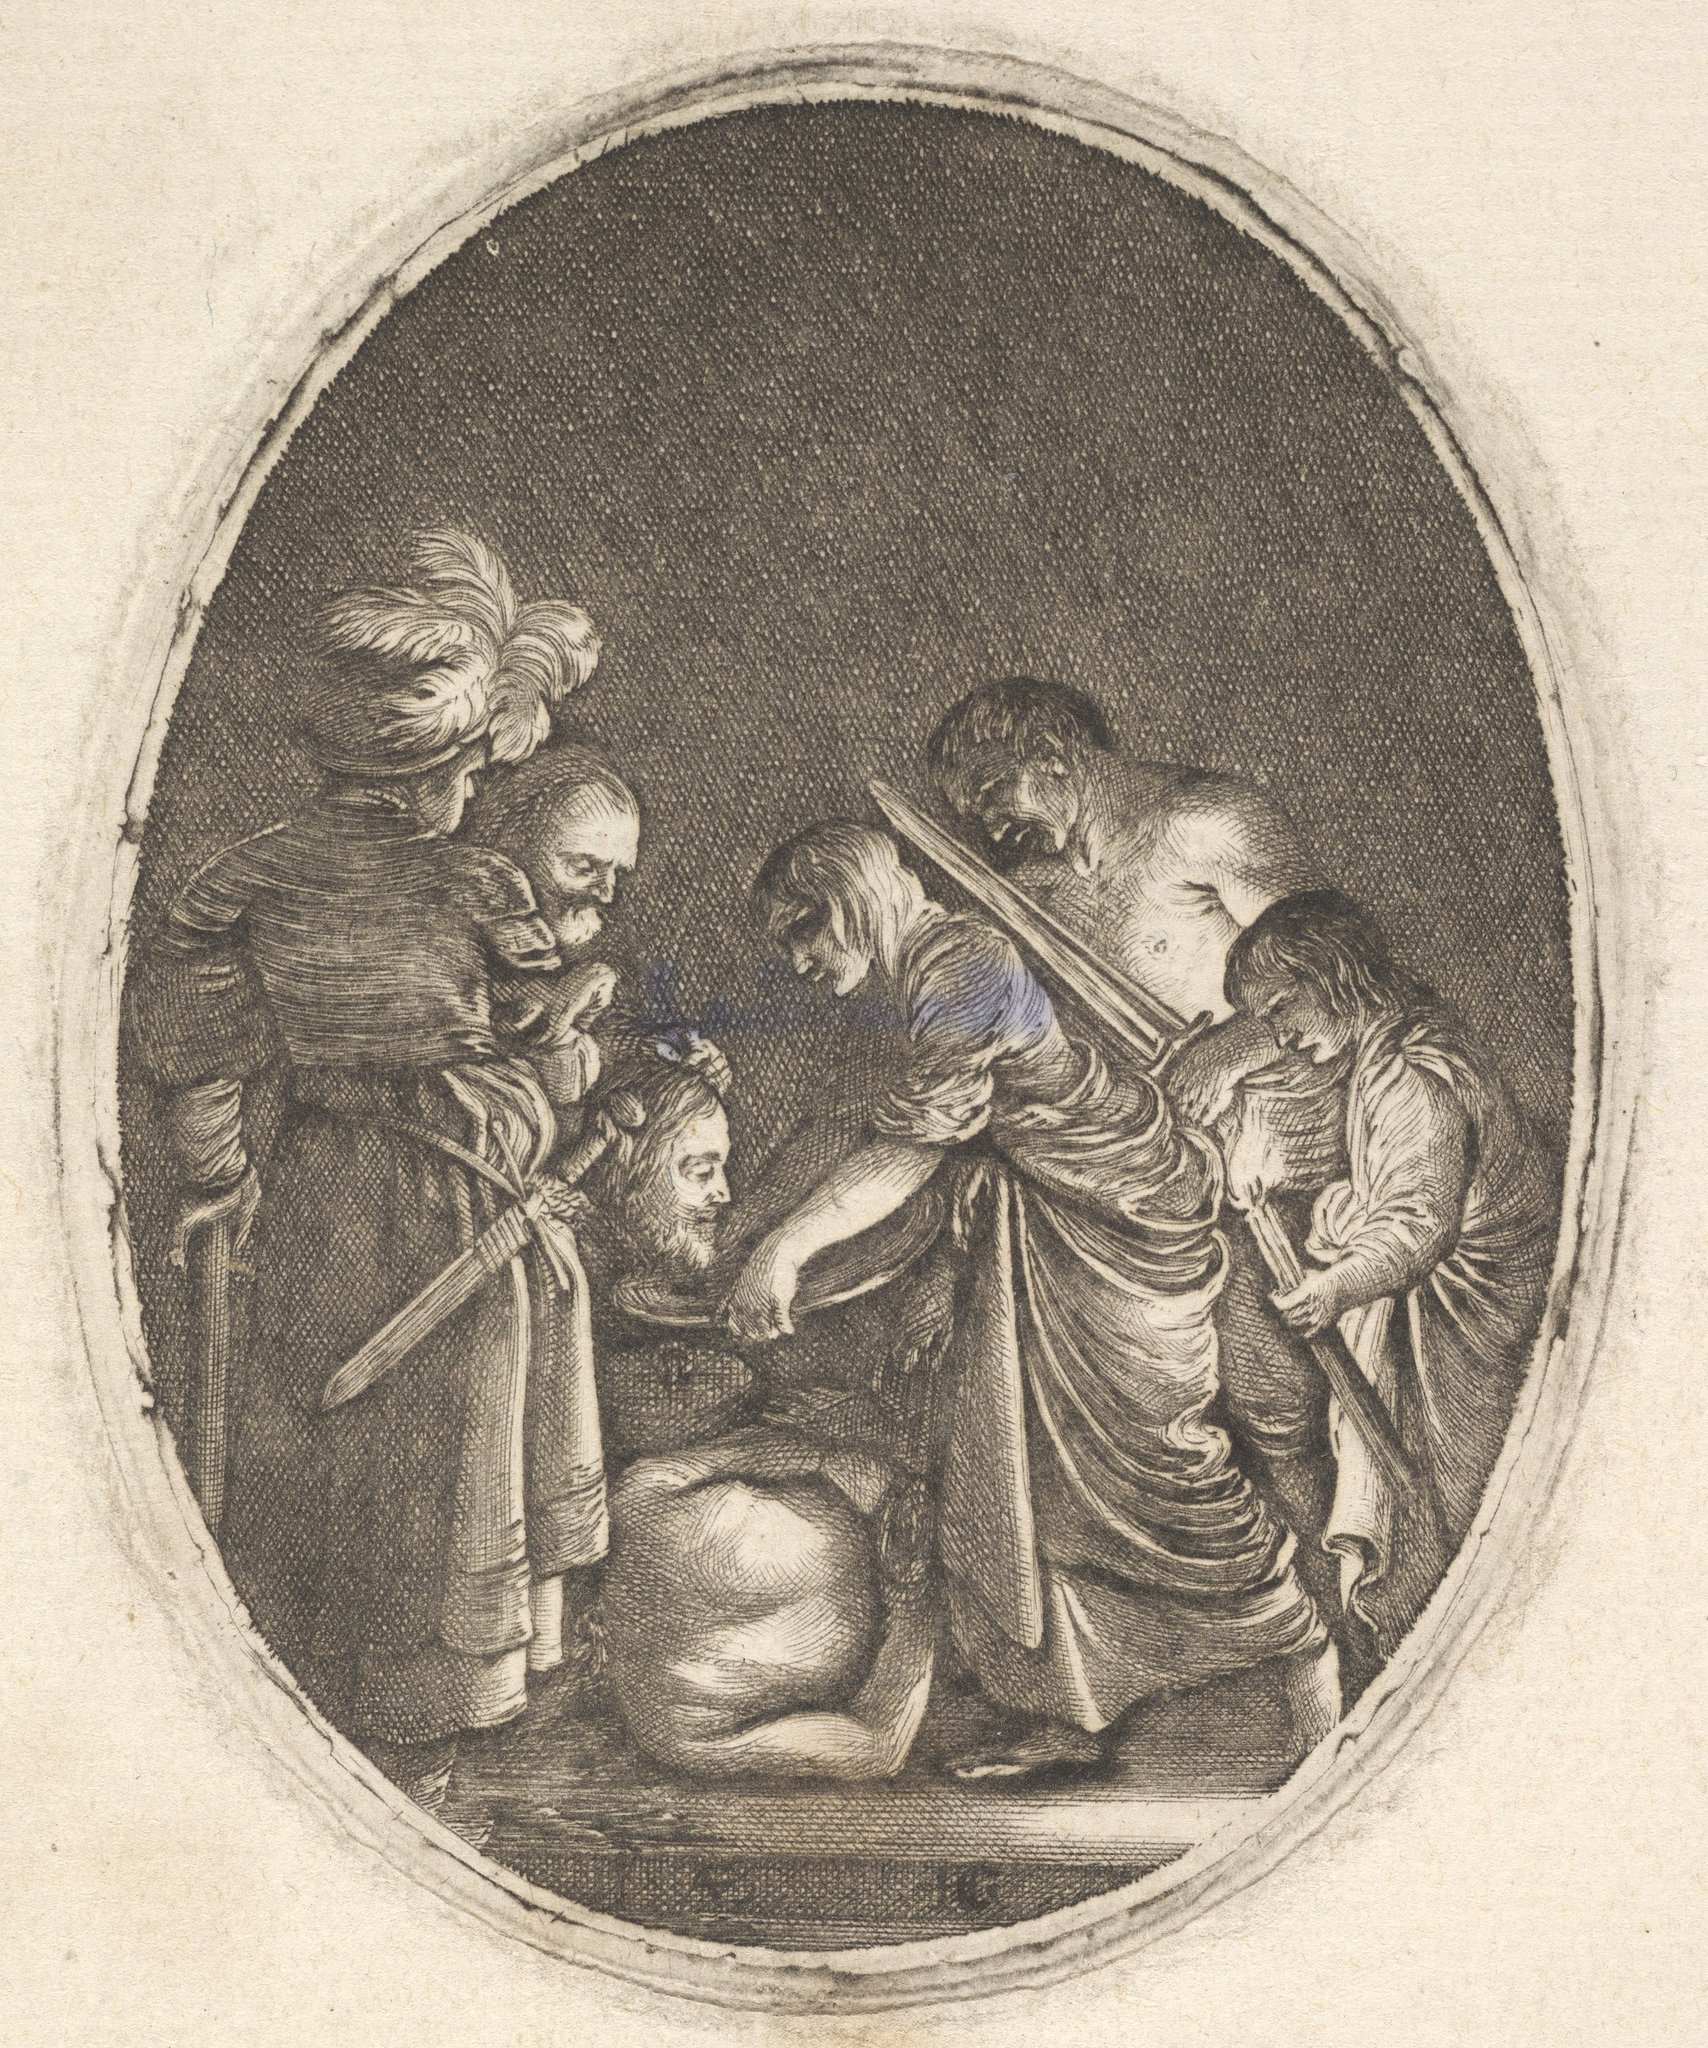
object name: print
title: Salome receiving the head of John the Baptist, surrounded by three men and a child bearing a torch, the Baptist's body lies on the ground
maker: hendrick goudt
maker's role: artist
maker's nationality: dutch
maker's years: 1580-1648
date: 1610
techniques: engraving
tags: corpses,boys,men,women,saint john the baptist